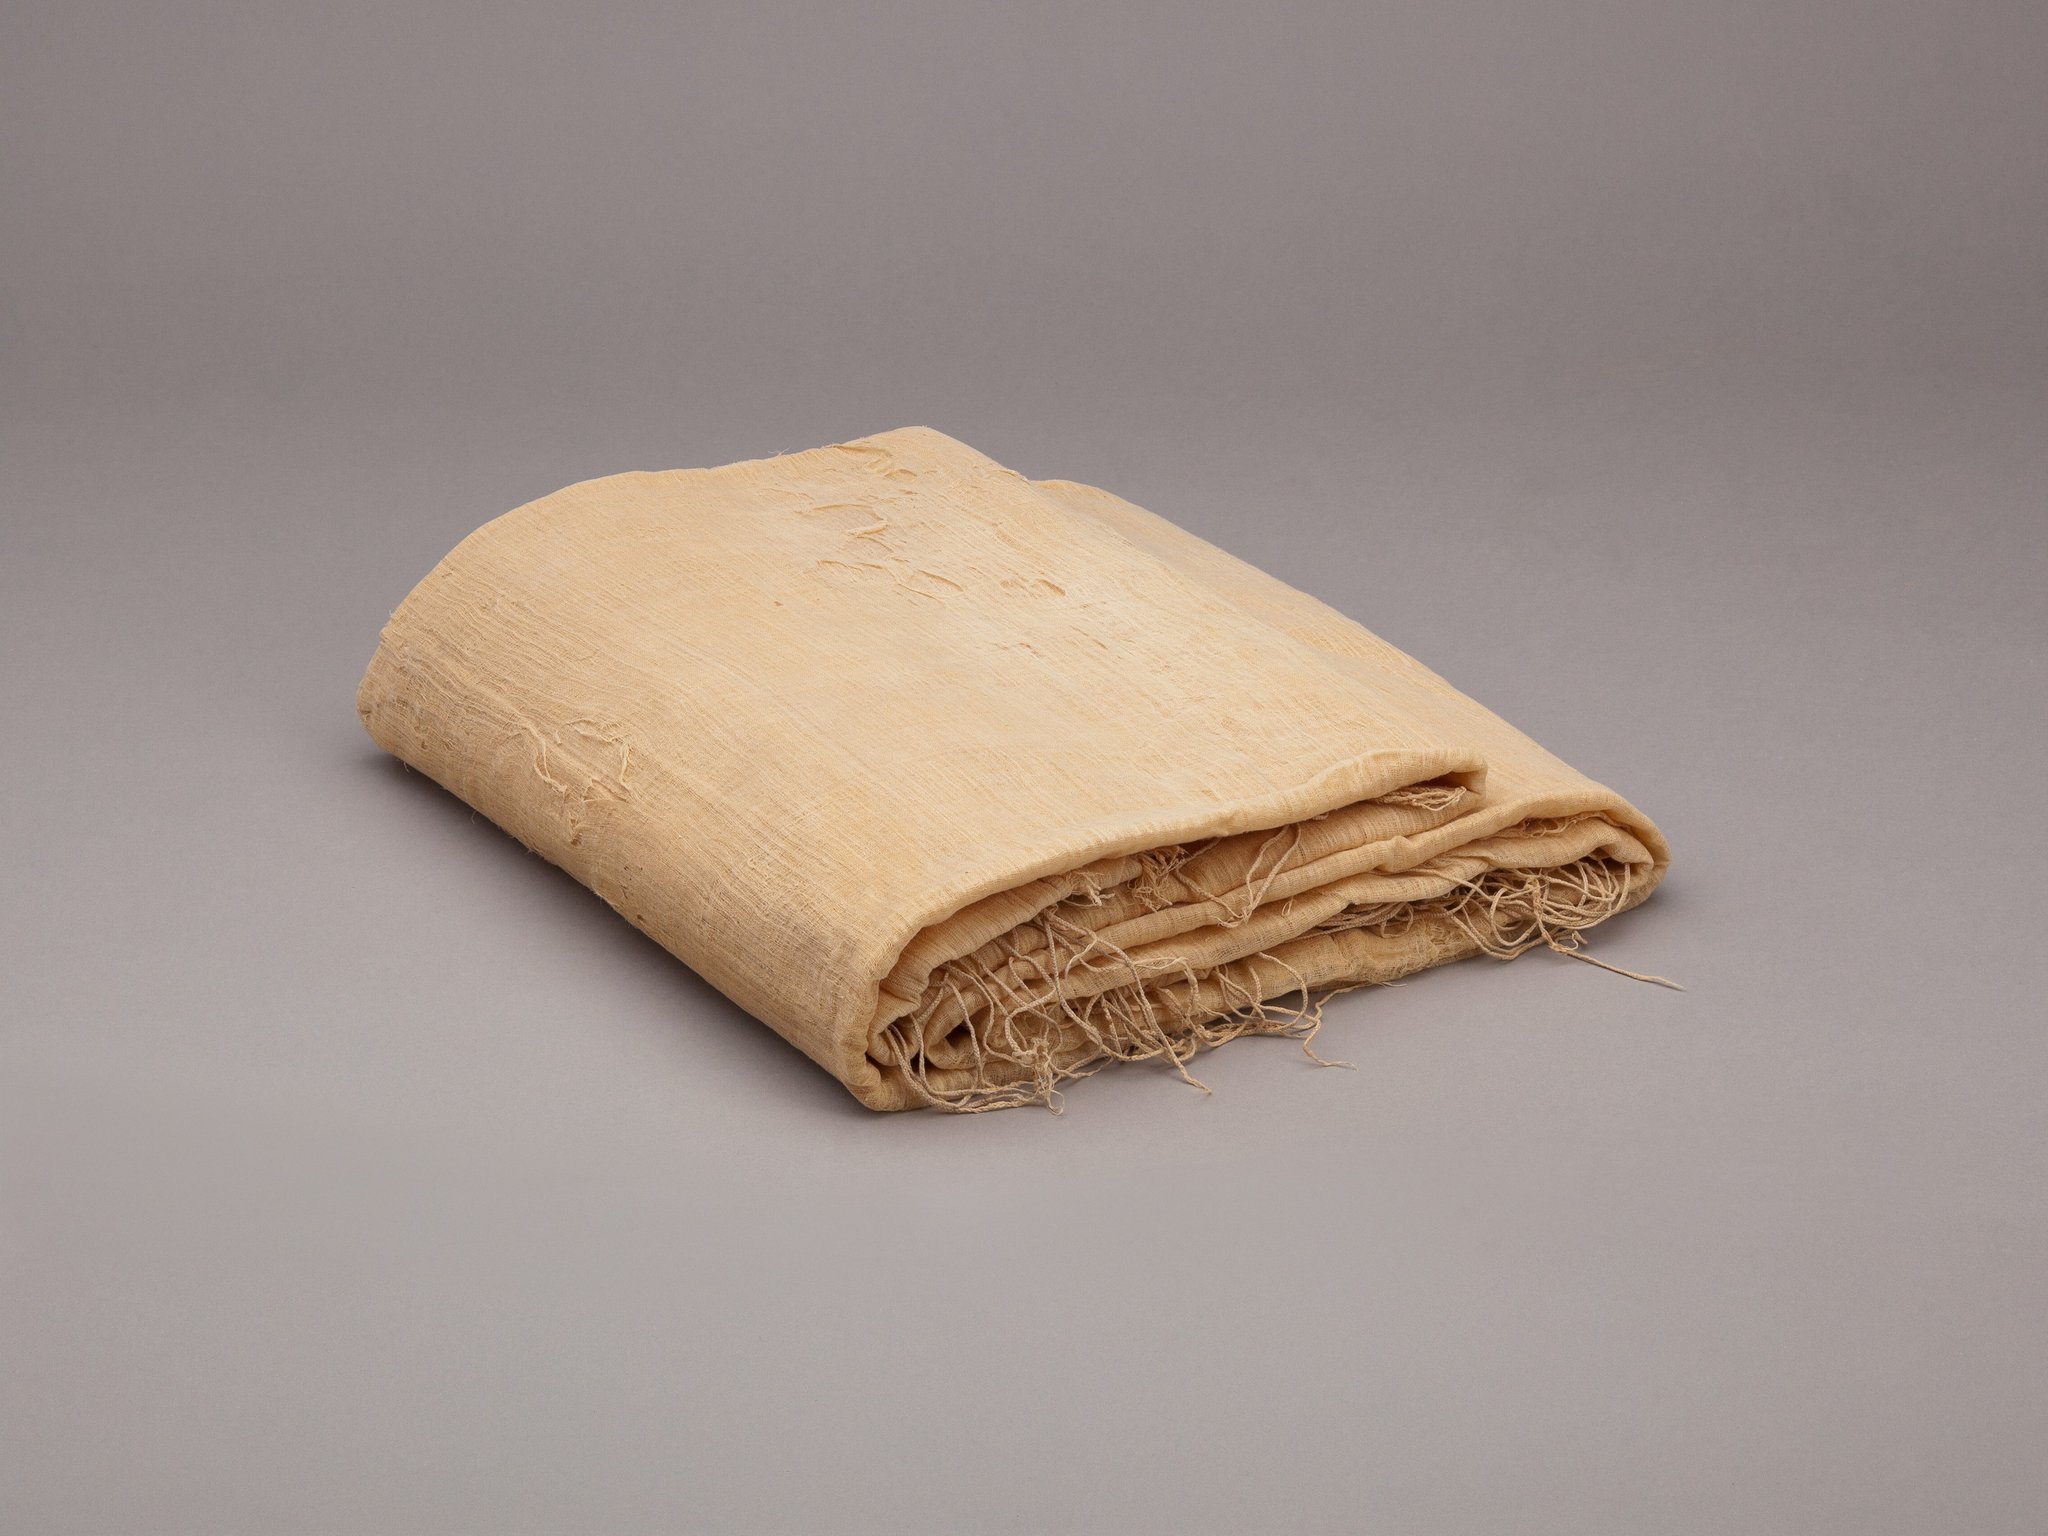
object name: linen mark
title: Sheet, linen mark, fine spin, medium weave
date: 1492-1473 BCE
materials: linen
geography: egypt